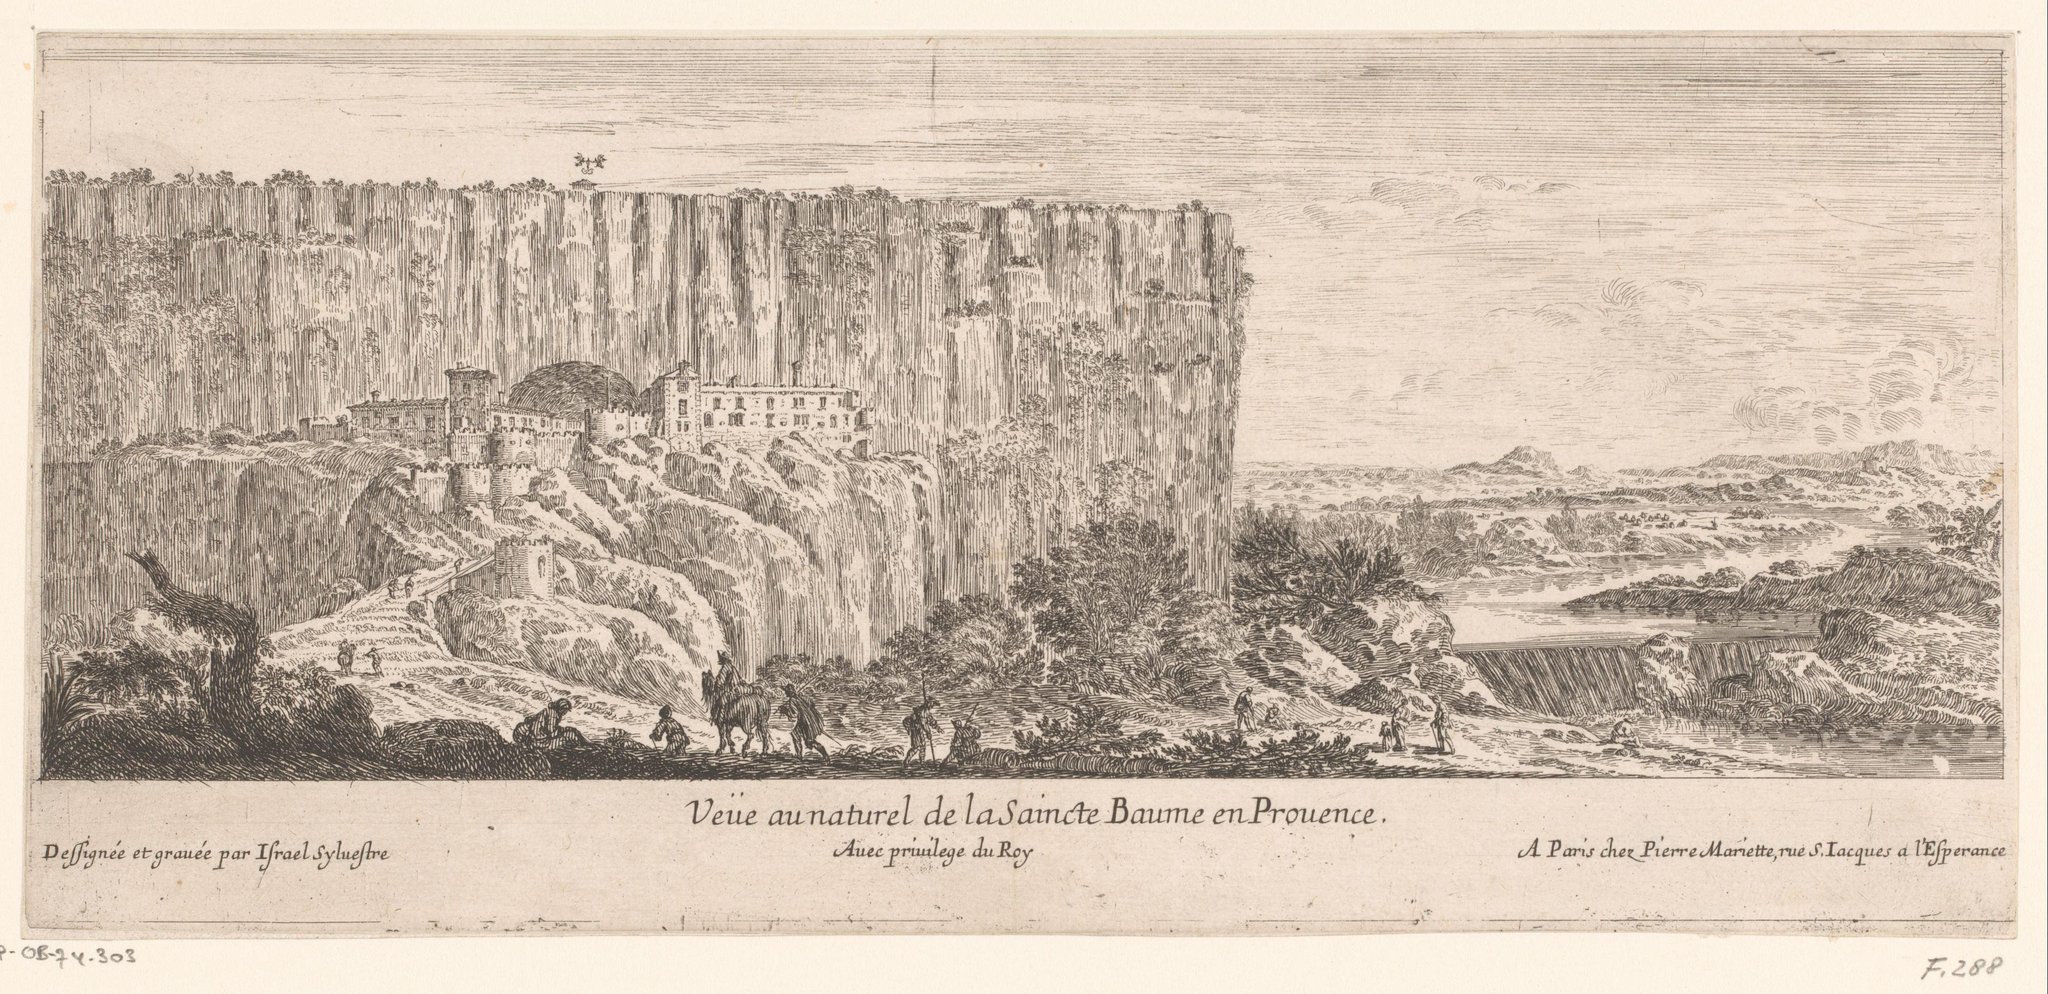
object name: print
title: Gezicht op de berg en grot van Sainte-Baume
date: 1631-1691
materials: paper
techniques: etching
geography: france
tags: city-view, and landscape with man-made constructions, cave, grotto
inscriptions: collector's mark: Lugt 240